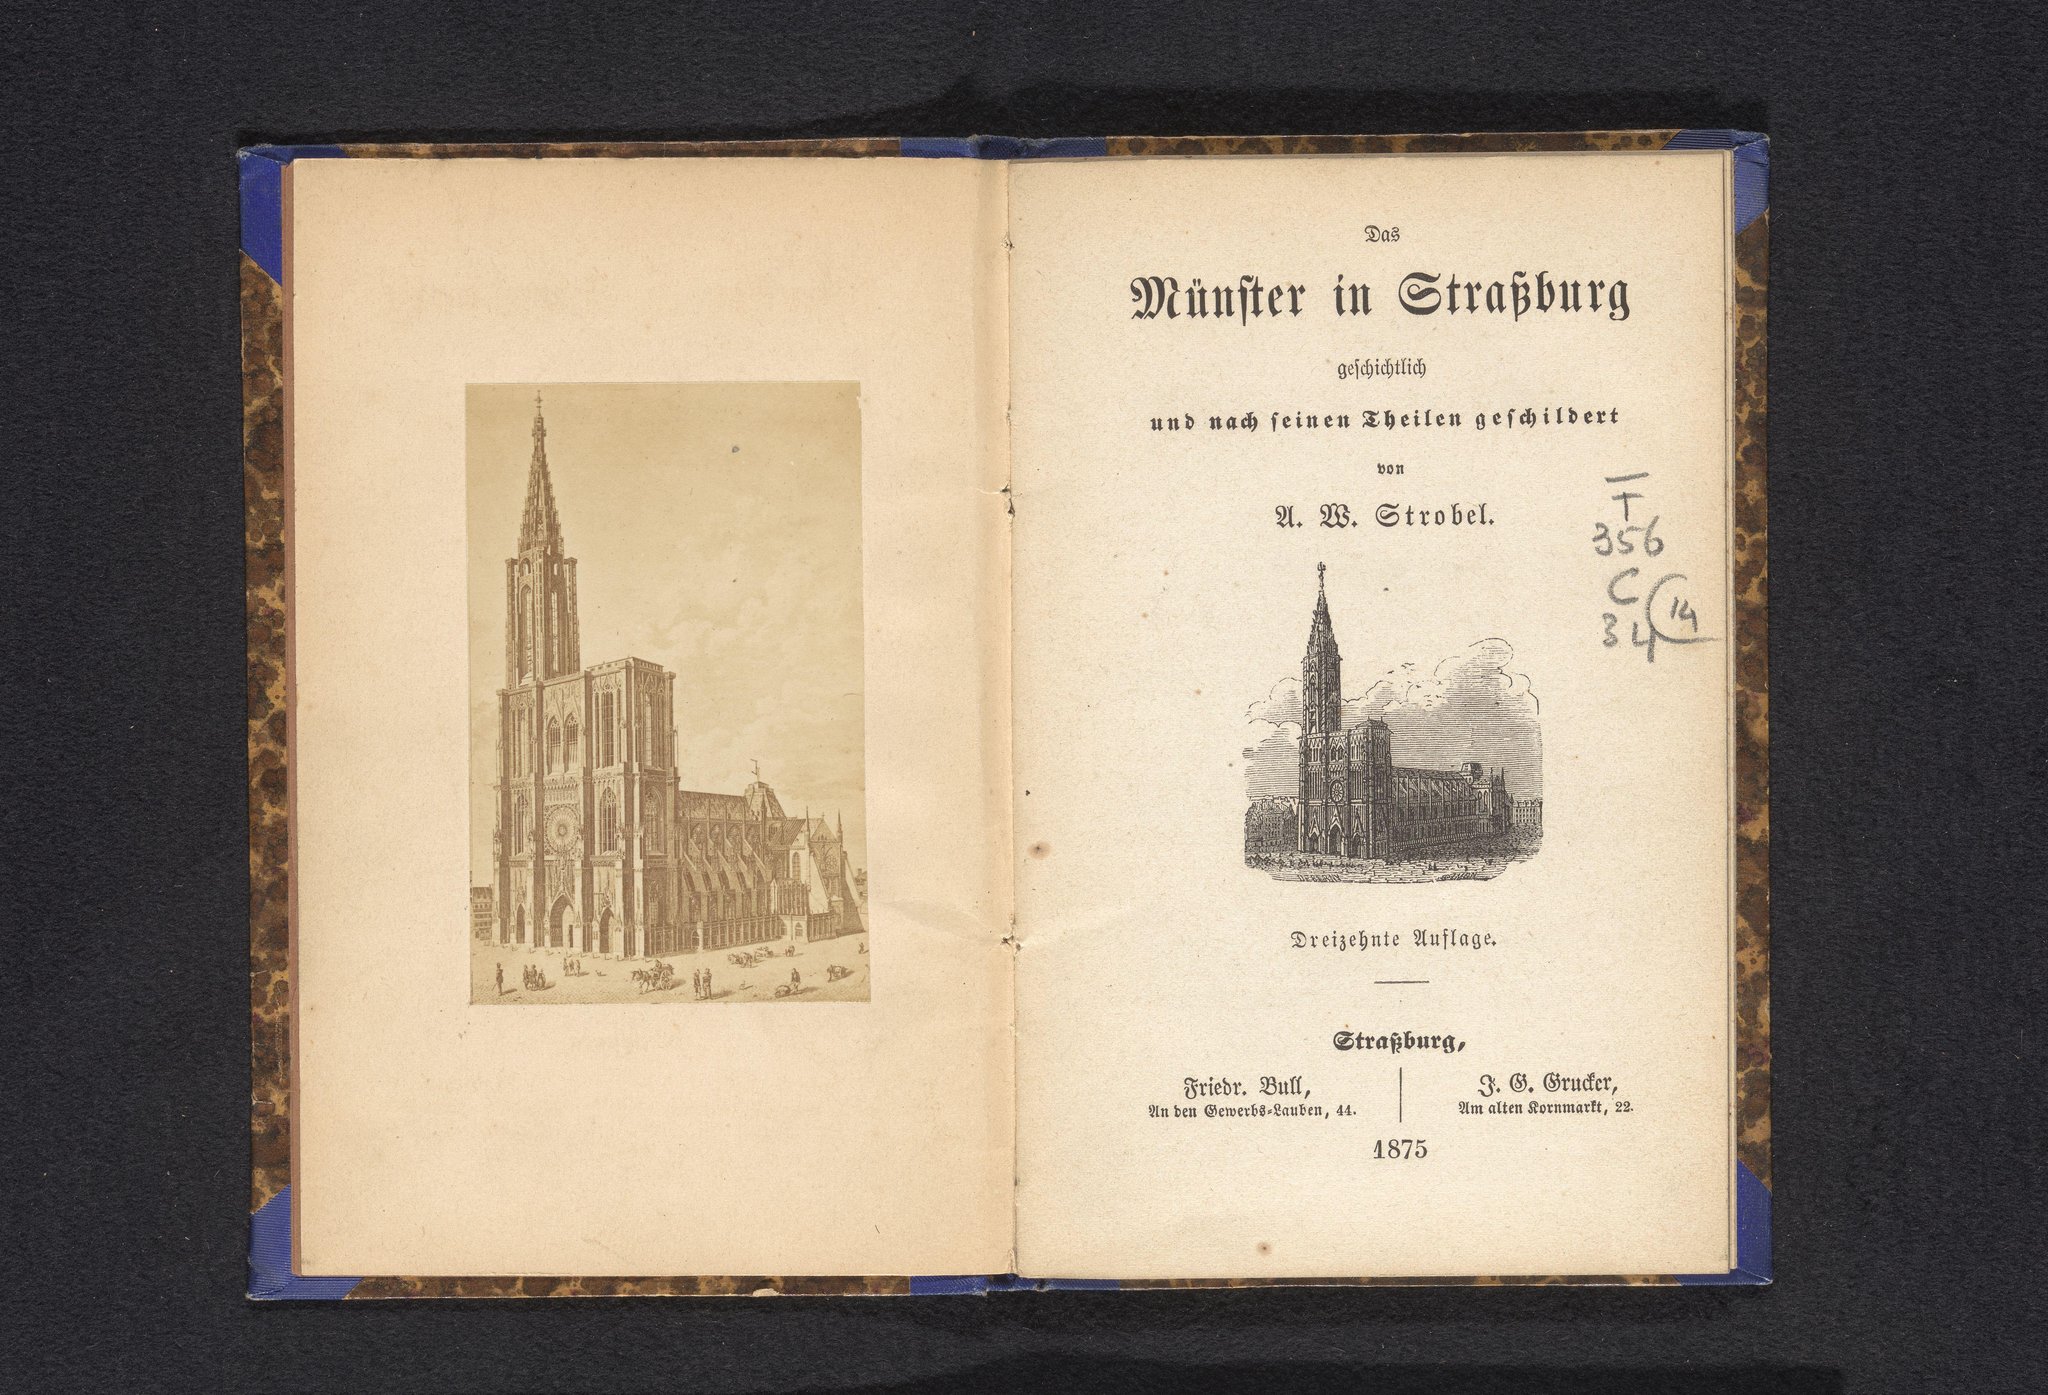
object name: reproduction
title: Fotoreproductie van een gezicht op de Kathedraal van Straatsburg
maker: Anonymous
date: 1882-1887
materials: photographic support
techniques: albumen print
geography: straatsburg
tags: church (exterior)